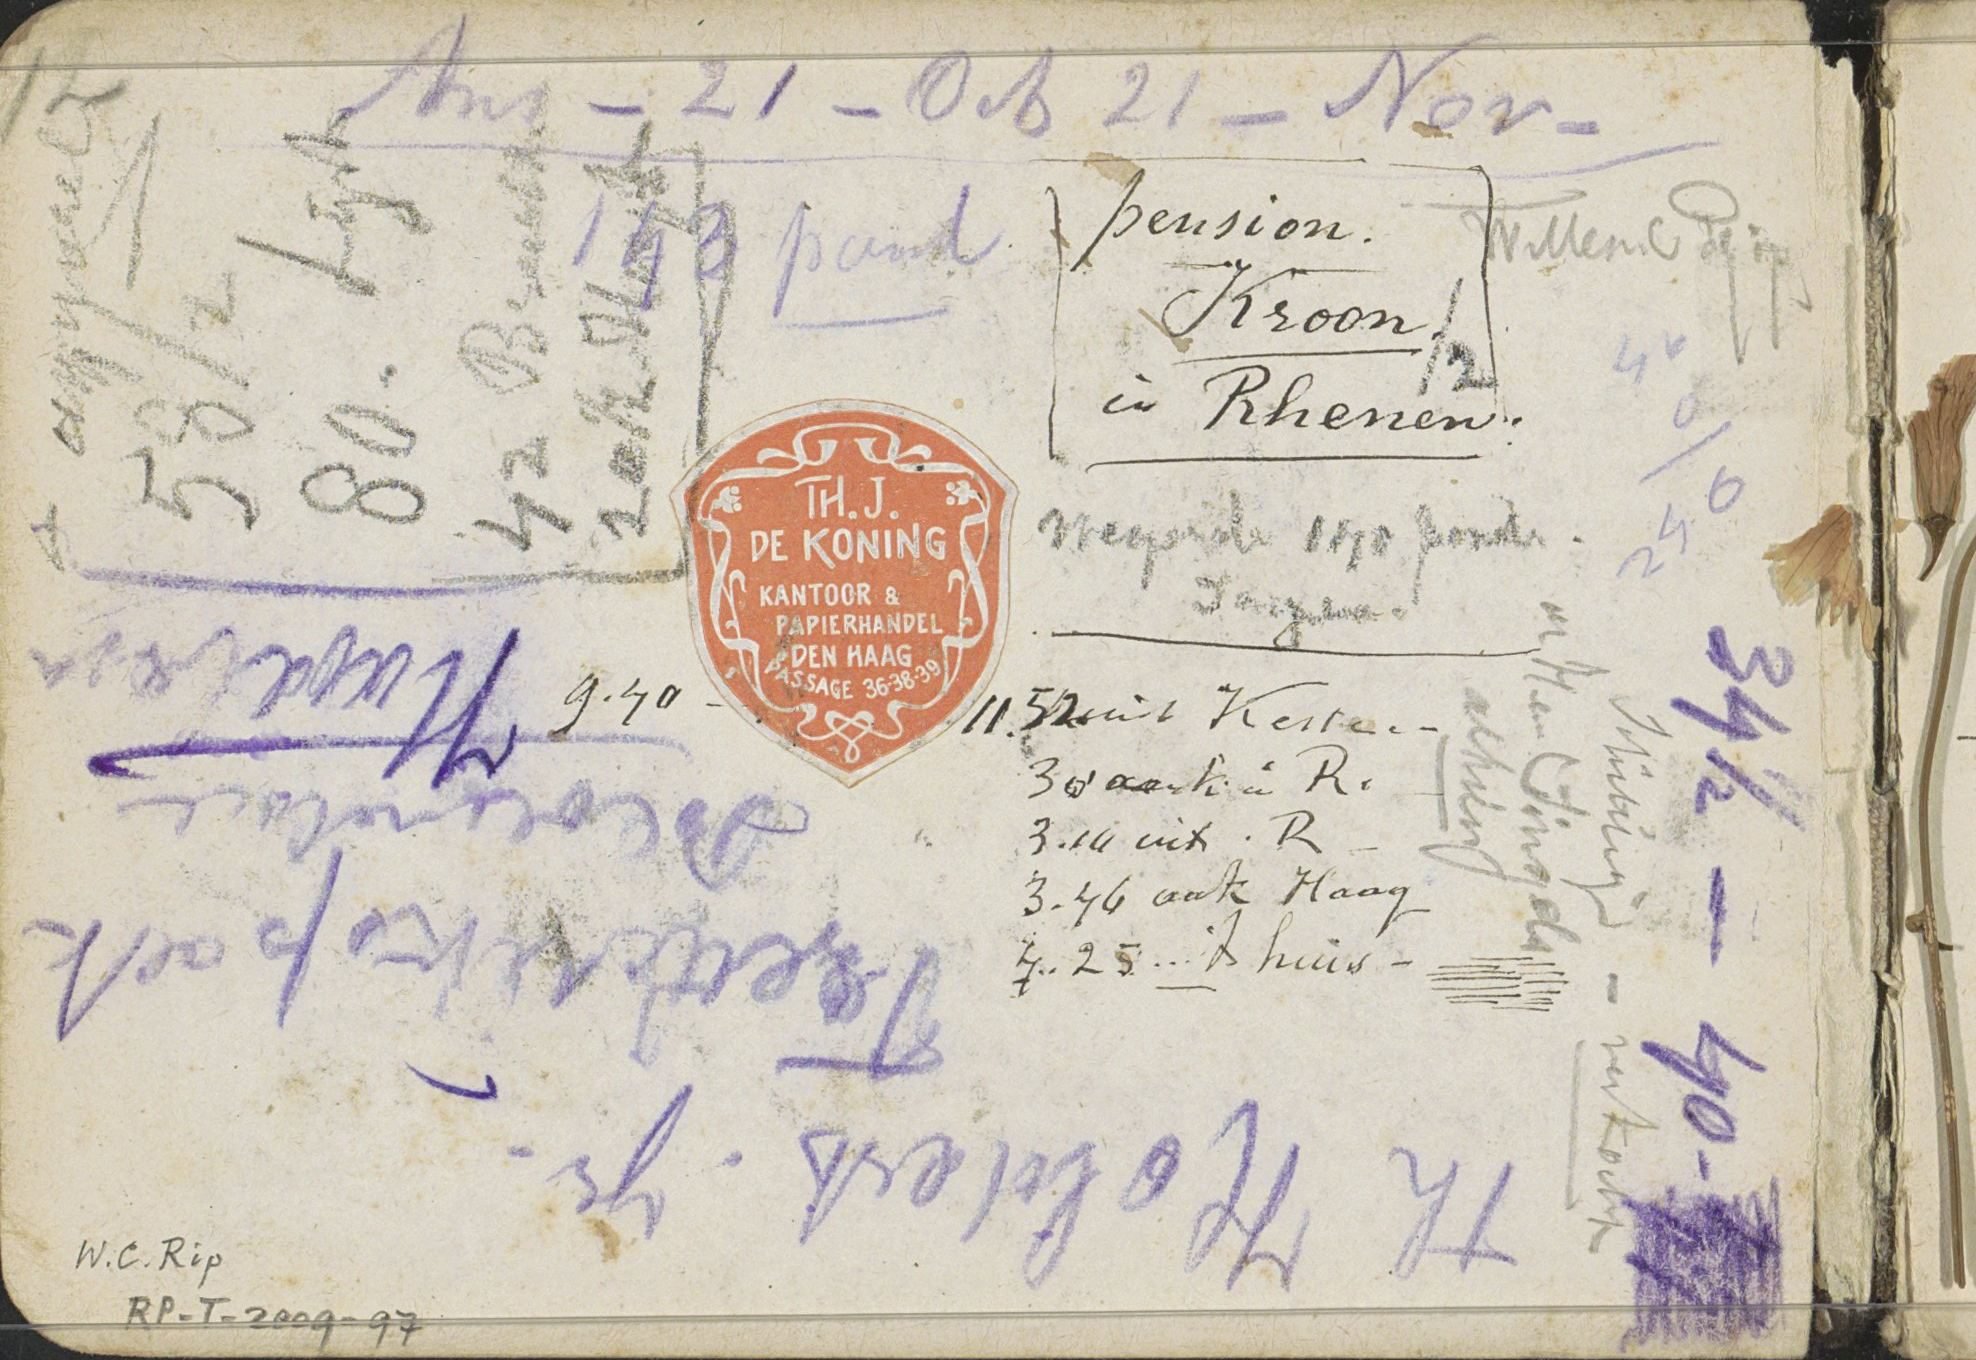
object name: sketchbook leaf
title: Notities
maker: willem cornelis rip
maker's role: draughtsman, painter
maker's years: 1856-1922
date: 1905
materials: chalk, ink, paper, pencil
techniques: pen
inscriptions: retailer's mark: ‘TH.J./ DE KONING/ Kantoor &/ Papierhandel/ Den Haag/ Passage 36-38-39’, annotation: ‘[...] pension/ Kroon/ in Rhenen/ [...]’, signature: ‘Willem C. Rip’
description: Voorste schutblad uit een schetsboek met 42 bladen.